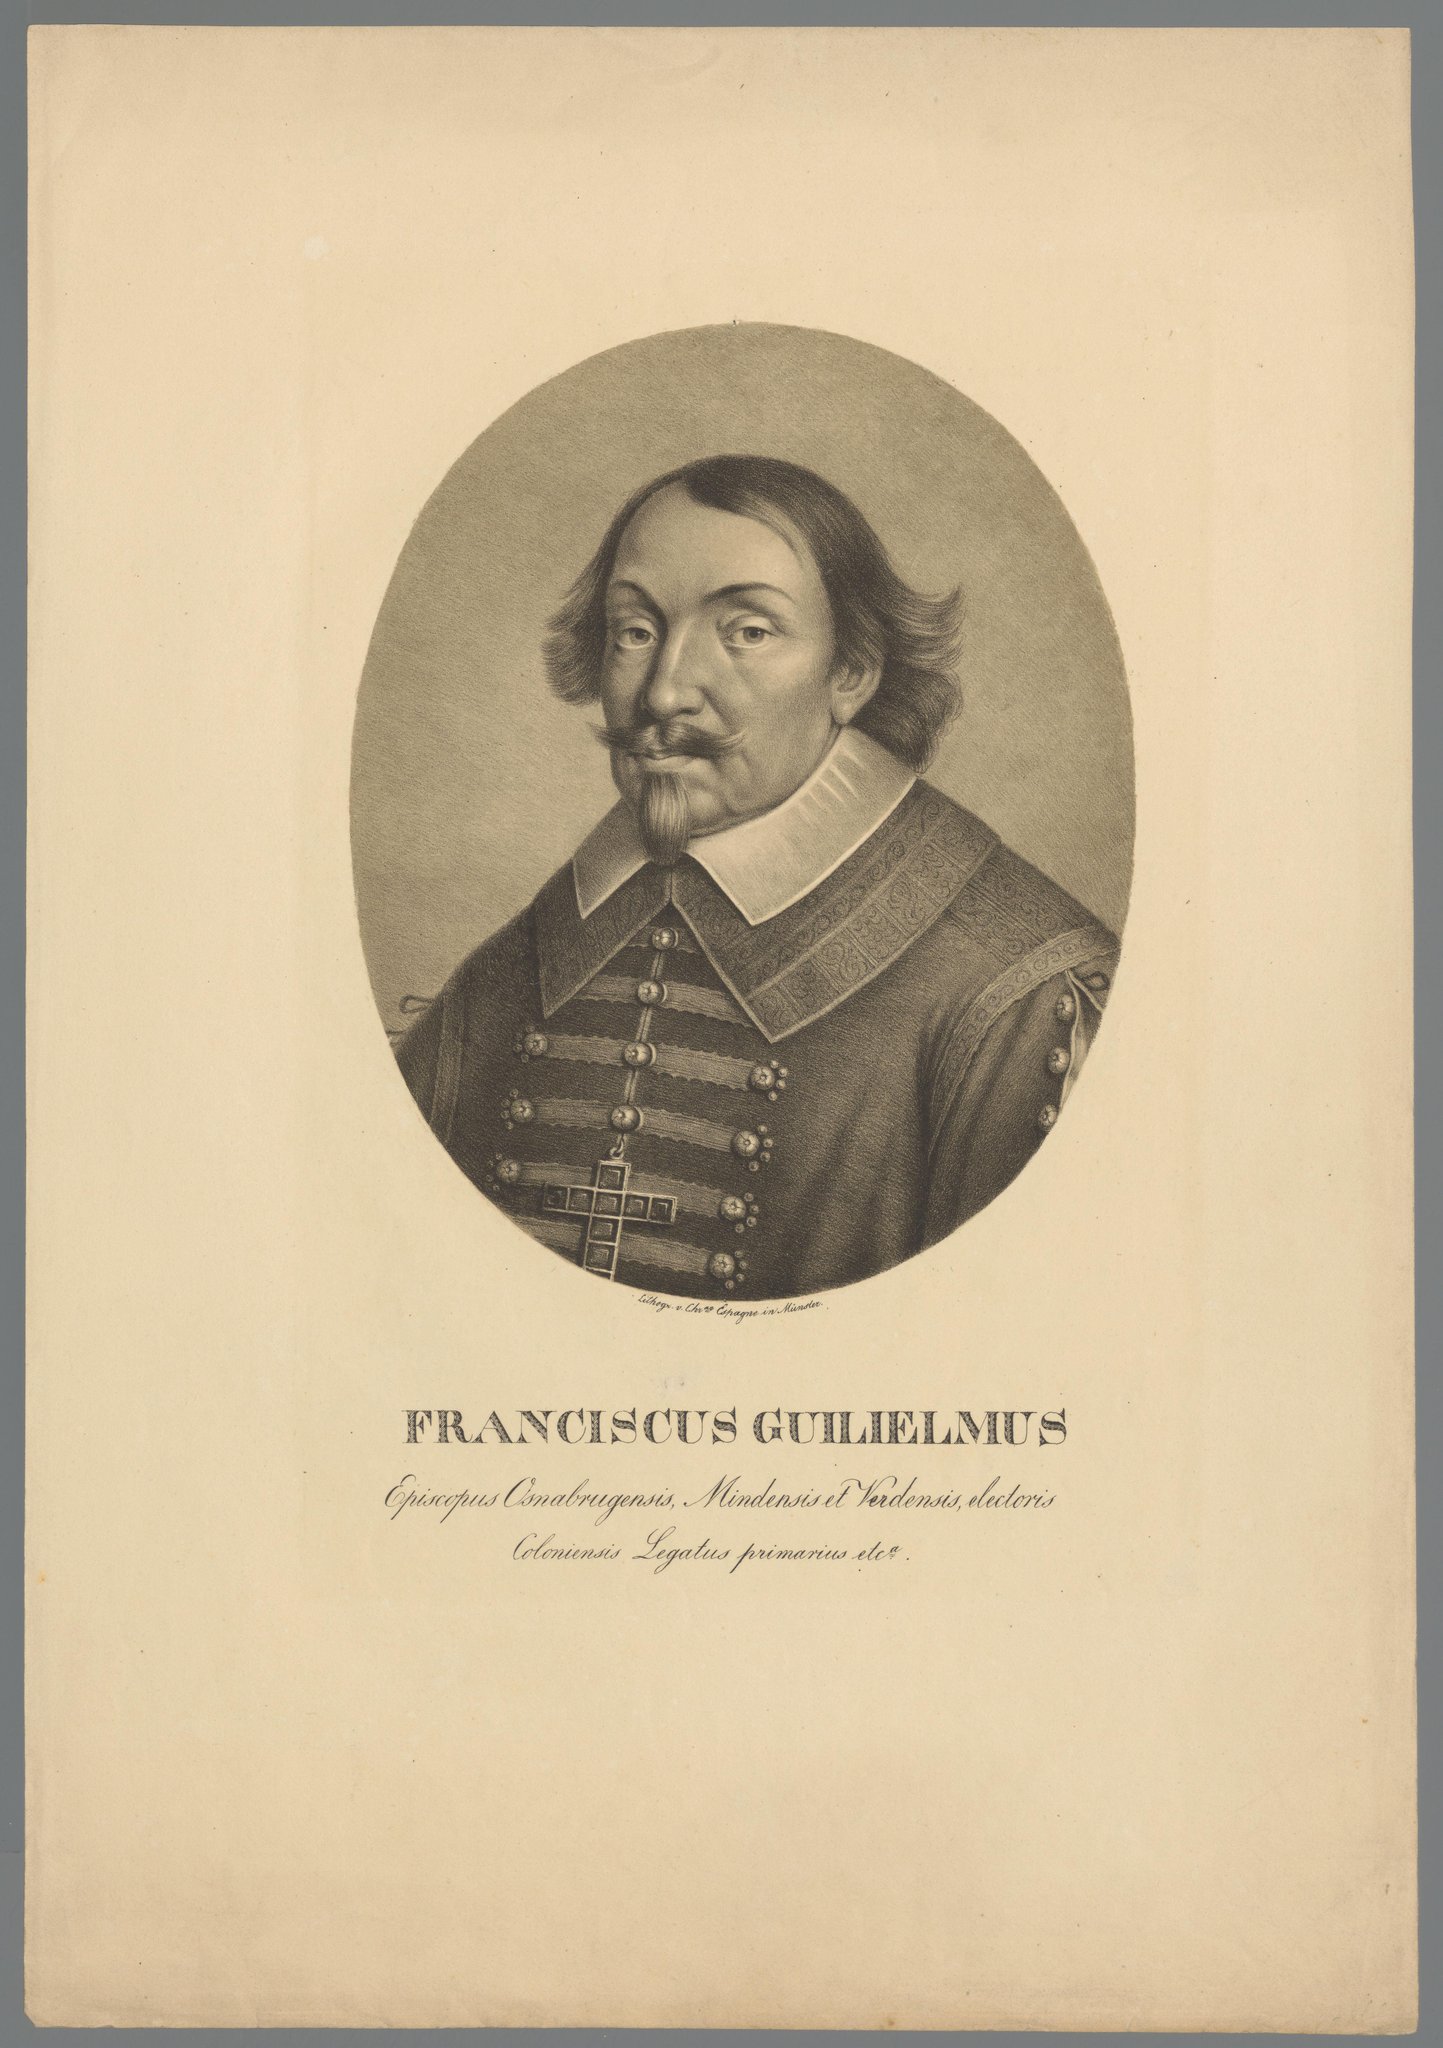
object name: print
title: Franciscus Guilielmus, (...) primarius etc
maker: christian espagne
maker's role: print maker, printer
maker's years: 1794-1838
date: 1824-1827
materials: paper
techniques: tone lithography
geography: munster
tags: priest, adult man, historical persons, beard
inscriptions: collector's mark: Lugt 2233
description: Prent uit: Bildnisse der beim westfälischen Friedensschluß zu Münster und Osnabrück versammelt gewesenen Gesandten. Münster: Christian Espagne, [1824-1827]. Deze publicatie bevat een onbekend aantal lithografieën, die in afleveringen verschenen als illustratie bij de tekst.